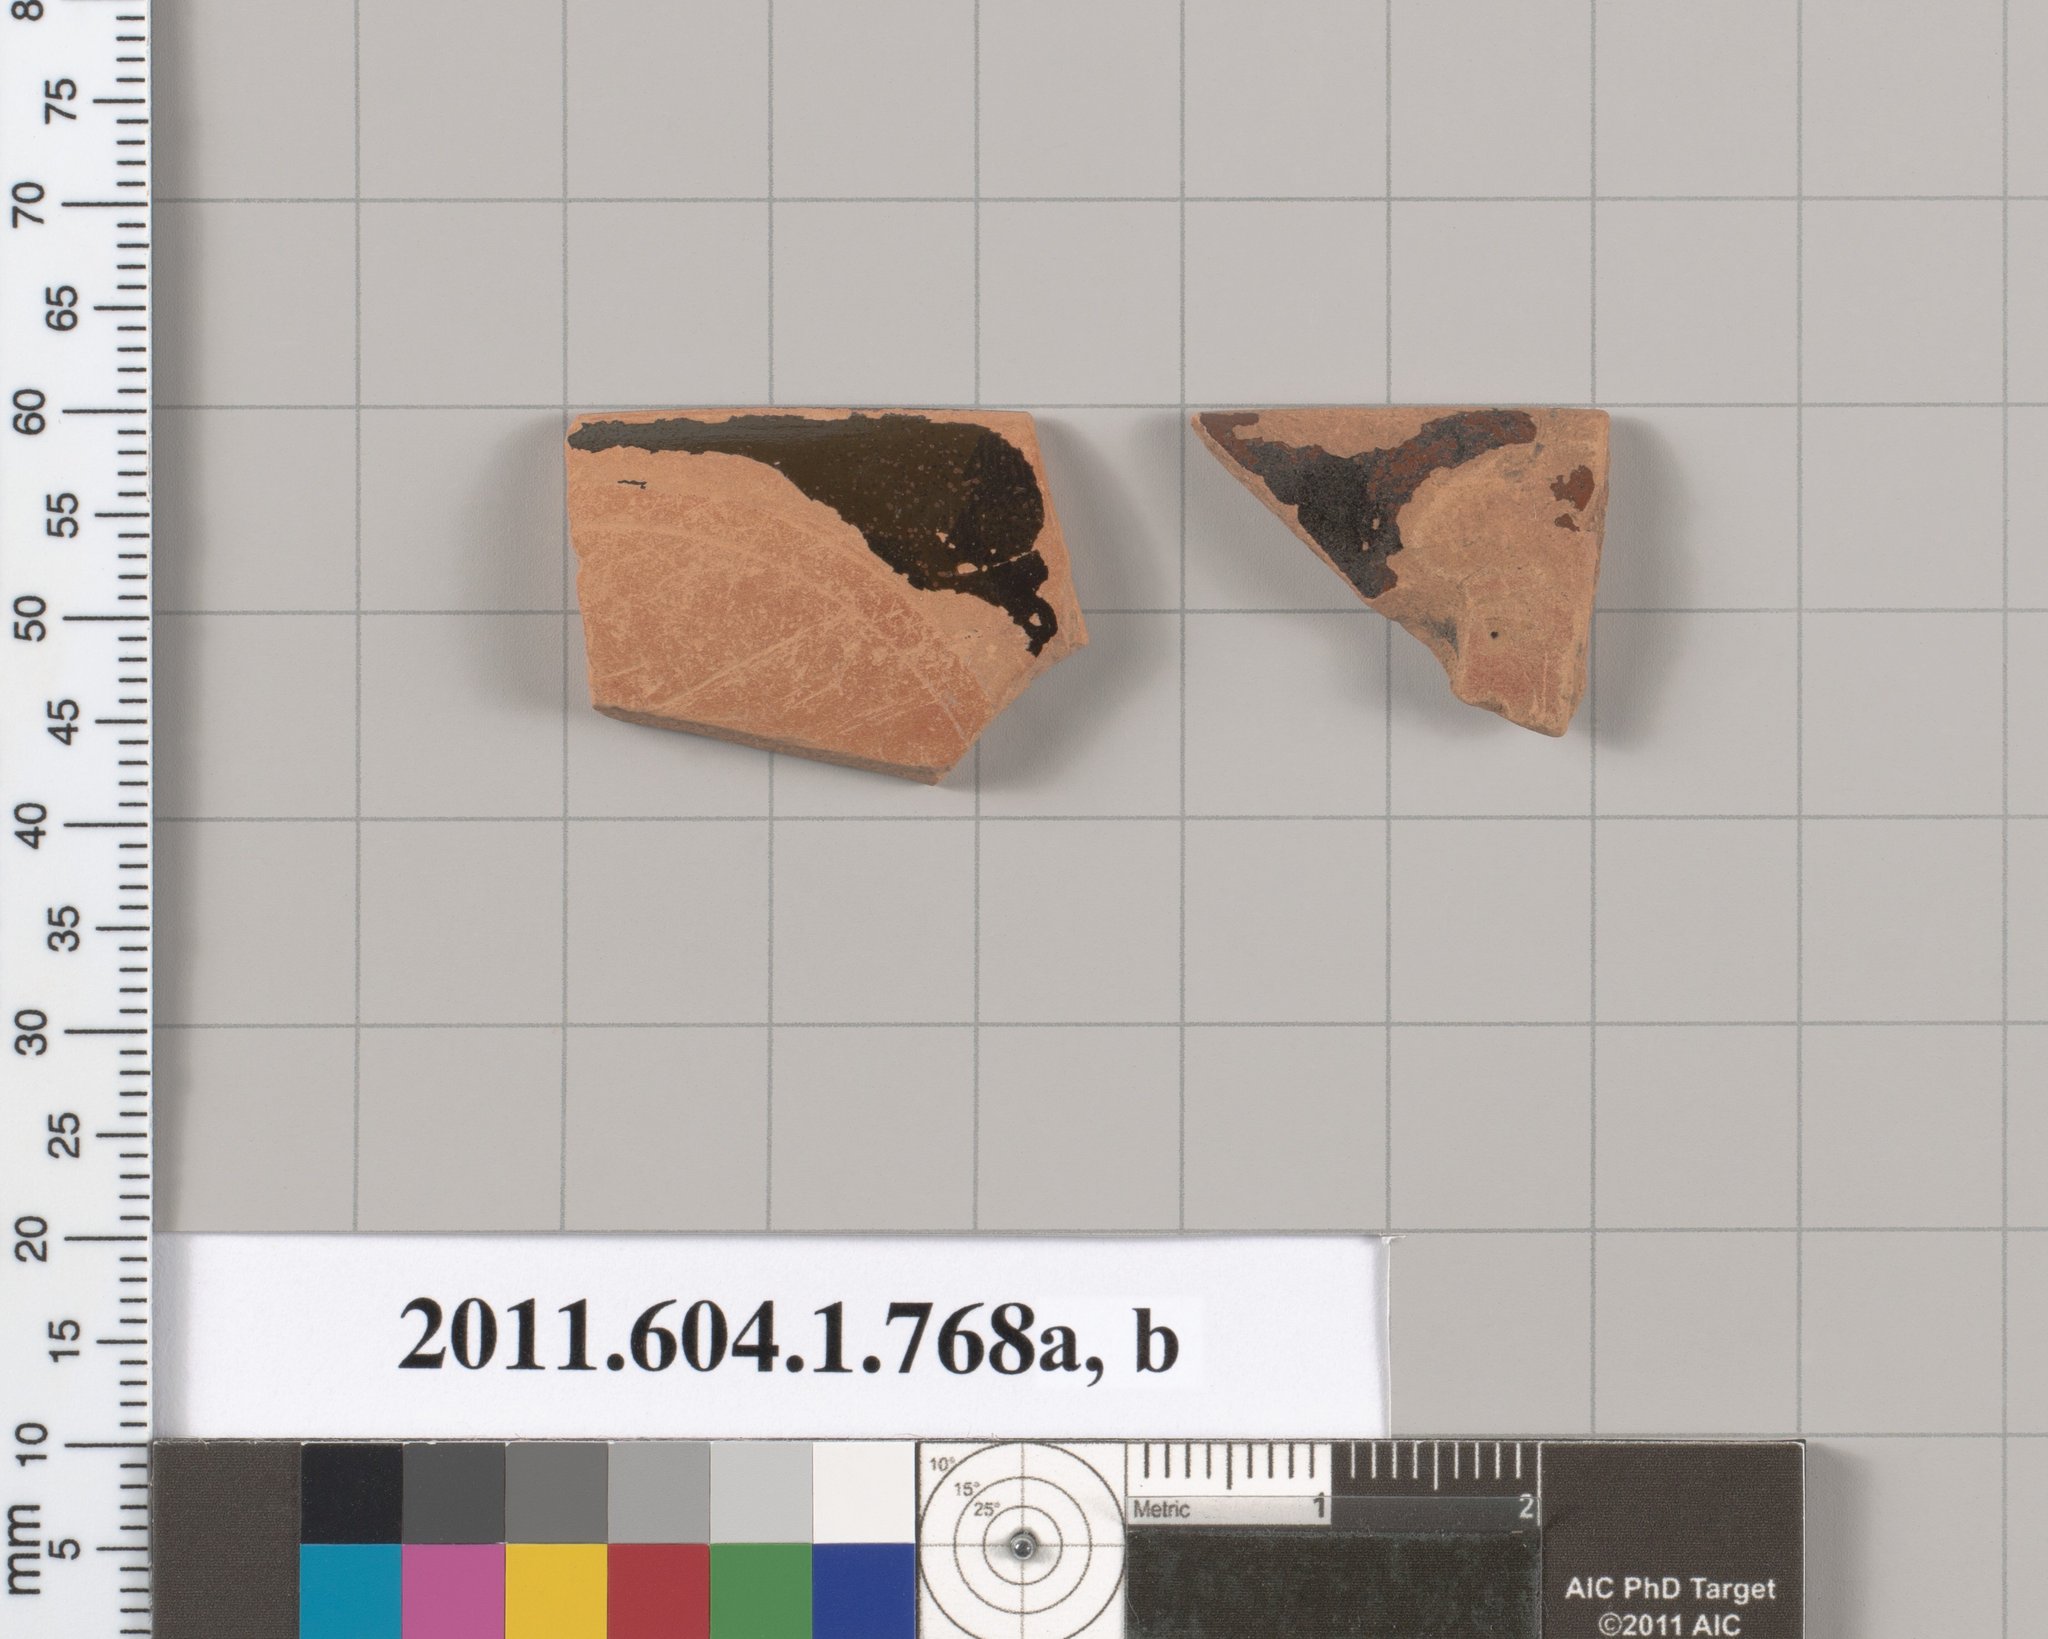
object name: kylix fragment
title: Terracotta rim fragments of a kylix (drinking cup)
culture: greek, attic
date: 500-401 BCE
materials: terracotta